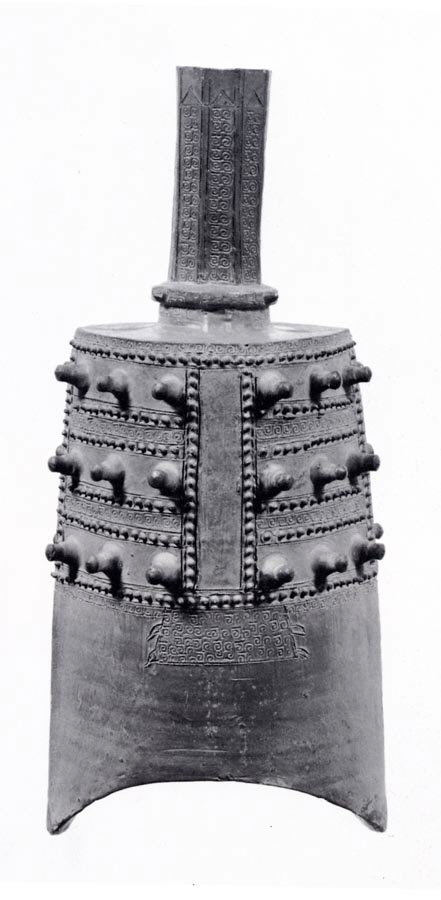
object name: bell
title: Model of a bell (Yong Zhong)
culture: chinese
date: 500-401 BCE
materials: earthenware